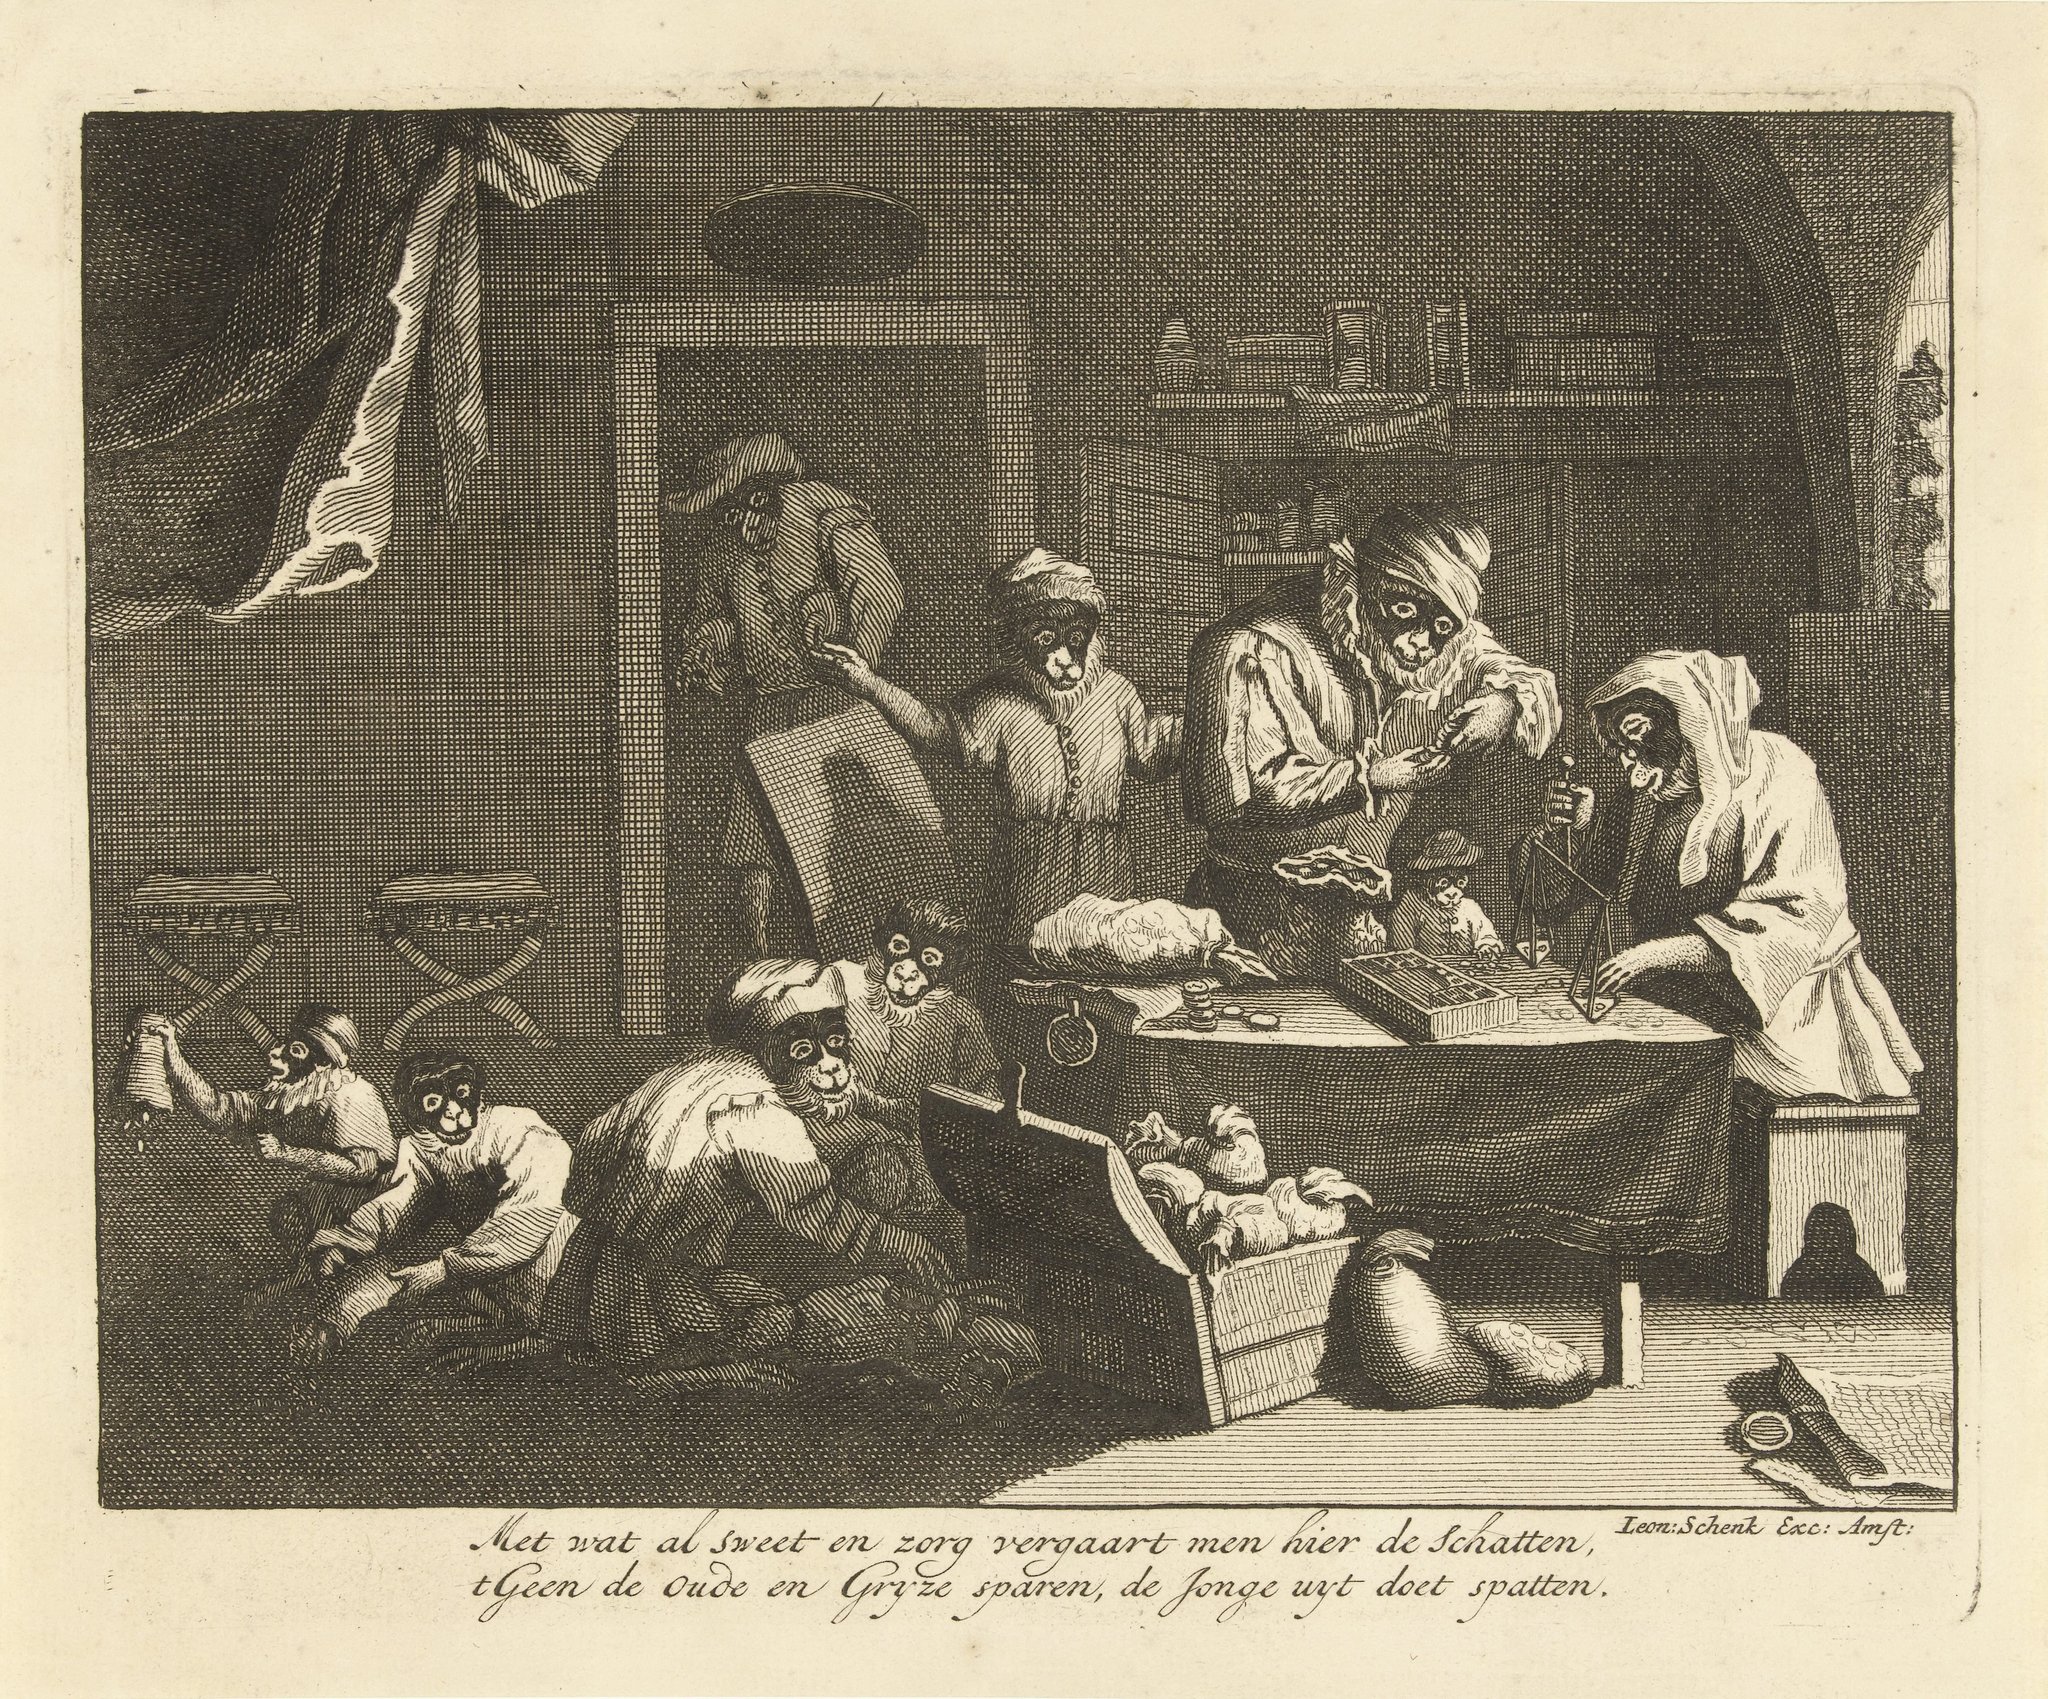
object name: print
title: 't Aapenspel in de Werelt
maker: leonard schenk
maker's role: print maker, publisher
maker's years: 1696-1767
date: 1720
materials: paper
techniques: engraving, etching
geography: amsterdam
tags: monkeys, apes, animals acting as human beings, weighing gold or money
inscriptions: collector's mark: Lugt 2228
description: Apen als bankiers, rechts weegt een aap geldstukken op een weegschaaltje. Onderdeel van een serie bestaande uit een titelprent met 16 ongenummerde platen uit ca. 1720 waarin apen als mensen figureren in allerlei taferelen uit het dagelijks leven. Elke prent met een tweeregelig vers in het onderschrift.